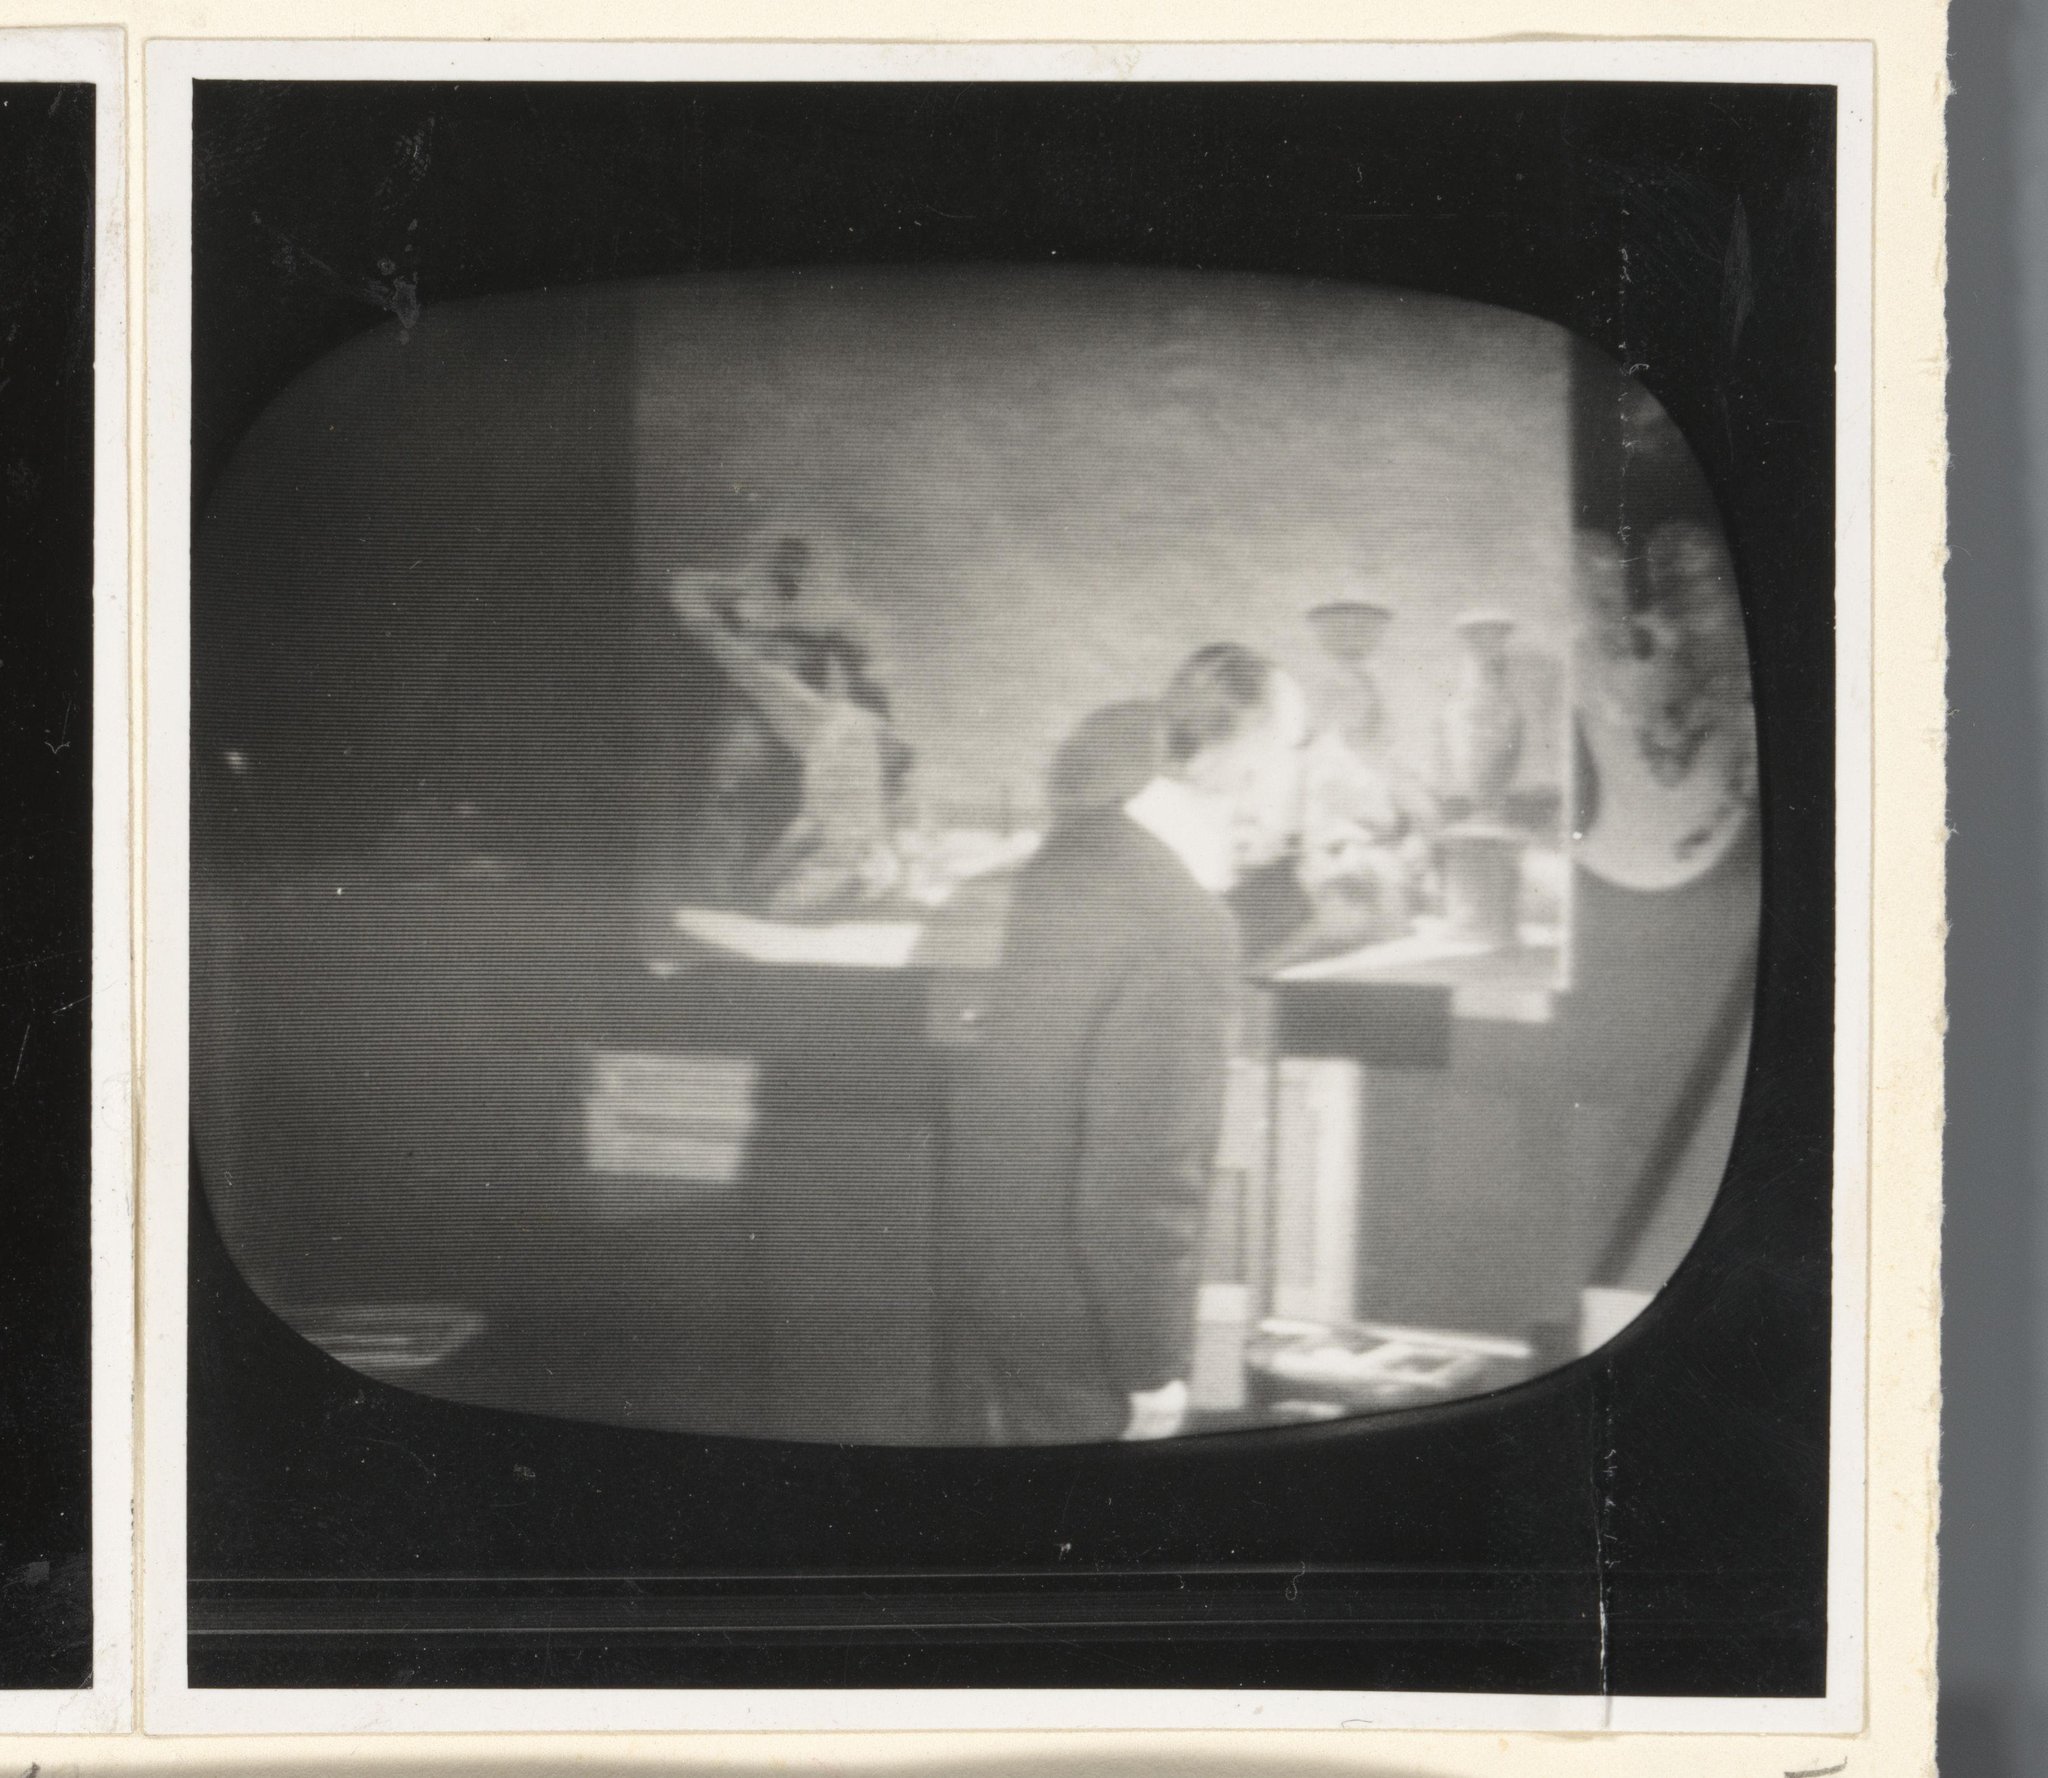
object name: photograph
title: Foto van televisiebeeldscherm, Carel Willink werkend aan het schilderij 'Evenwicht der krachten' (1963), waarschijnlijk tijdens de uitzending van de film 'Carel Willink' door Helène van Zijl, Lies Westenburg en Hans Redeker (1963)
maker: Anonymous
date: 1963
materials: cardboard, paper, photographic support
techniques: gelatin silver print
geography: netherlands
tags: television, television broadcasting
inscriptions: stamp: ‘FOTO E. VAN MOERKERKEN / COPYRIGHT / E. VAN MOERKERKEN / AMSTERDAM / No.’